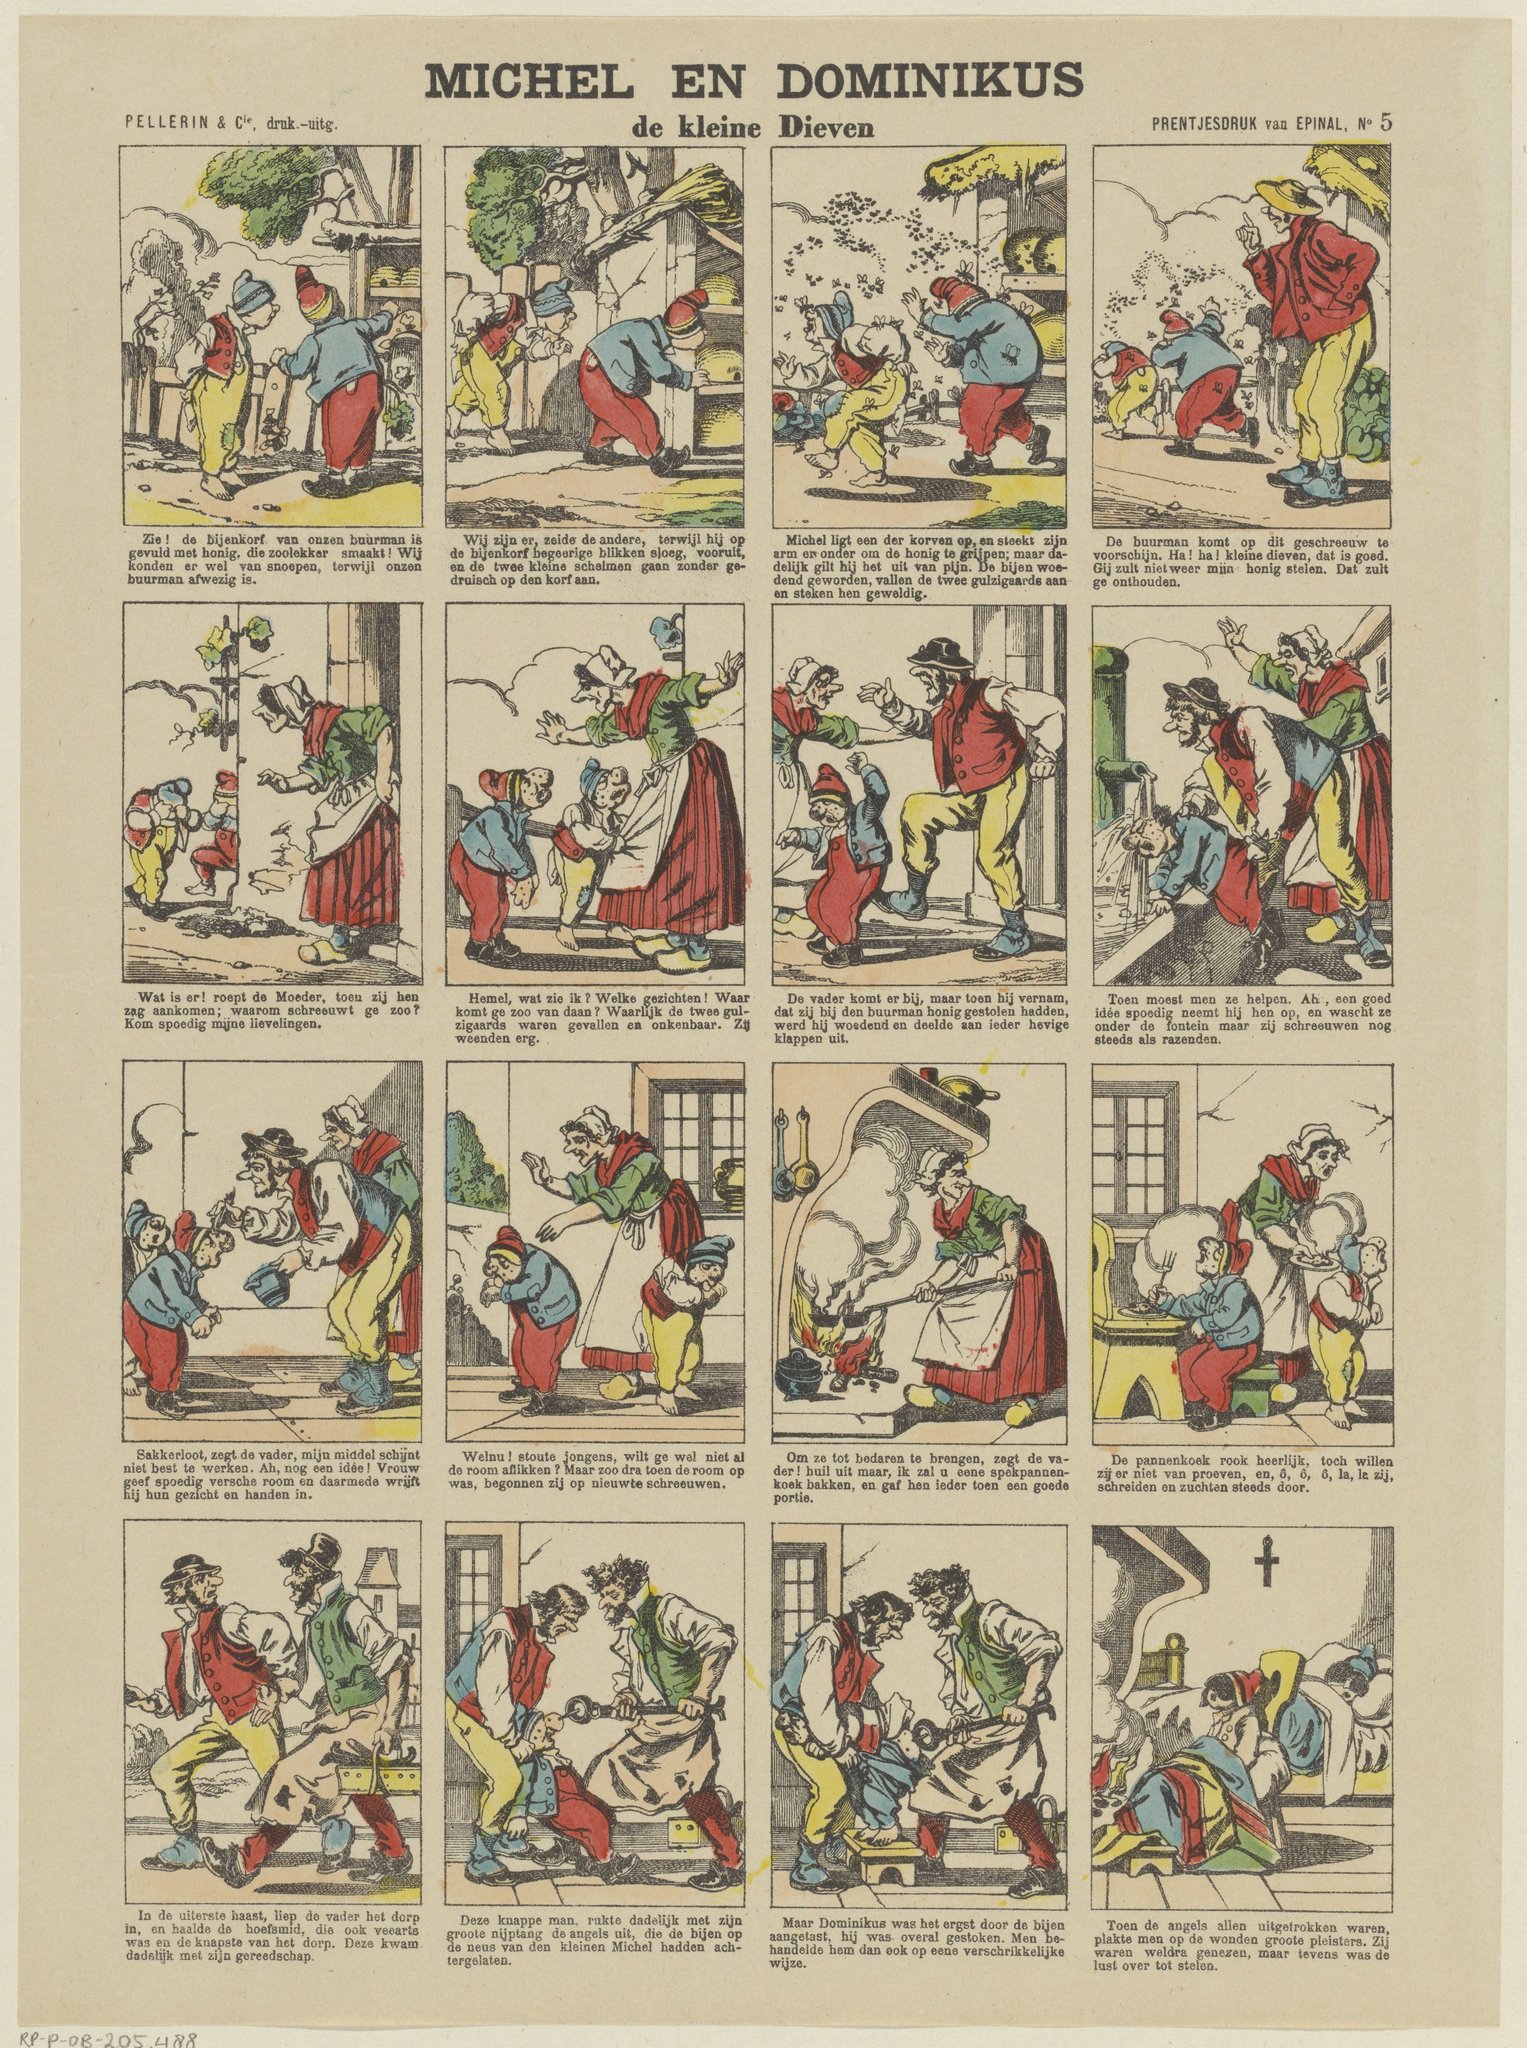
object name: popular print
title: Prentjesdruk van Épinal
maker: Anonymous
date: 1902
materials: paper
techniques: colour, letterpress printing, lithograph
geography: epinal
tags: bee-hive, tales and fairy tales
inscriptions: collector's mark: Lugt 2760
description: Blad met 16 voorstellingen uit het verhaal over de de twee deugnieten Michel en Dominikus, die honing stelen en gestoken worden door bijen. Onder elke afbeelding een onderschrift. Genummerd rechtsboven: No 5.